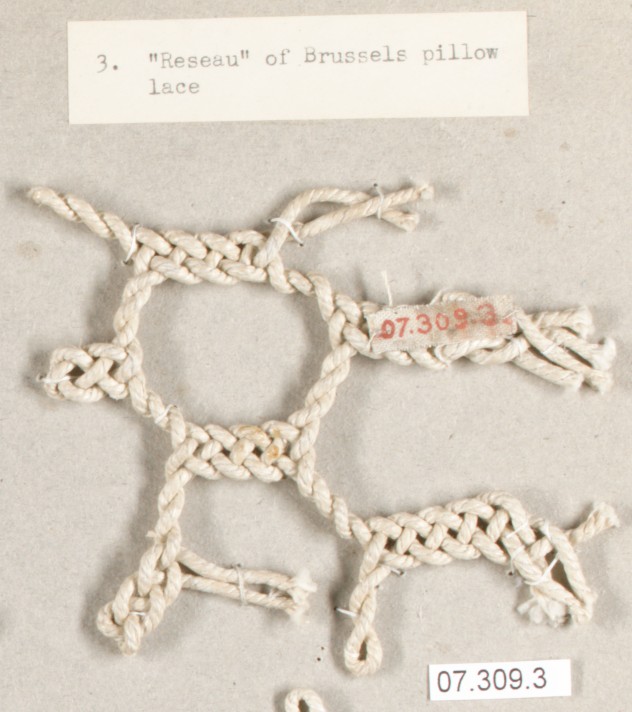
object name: stitch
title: Example of lace stitch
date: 1801-2000